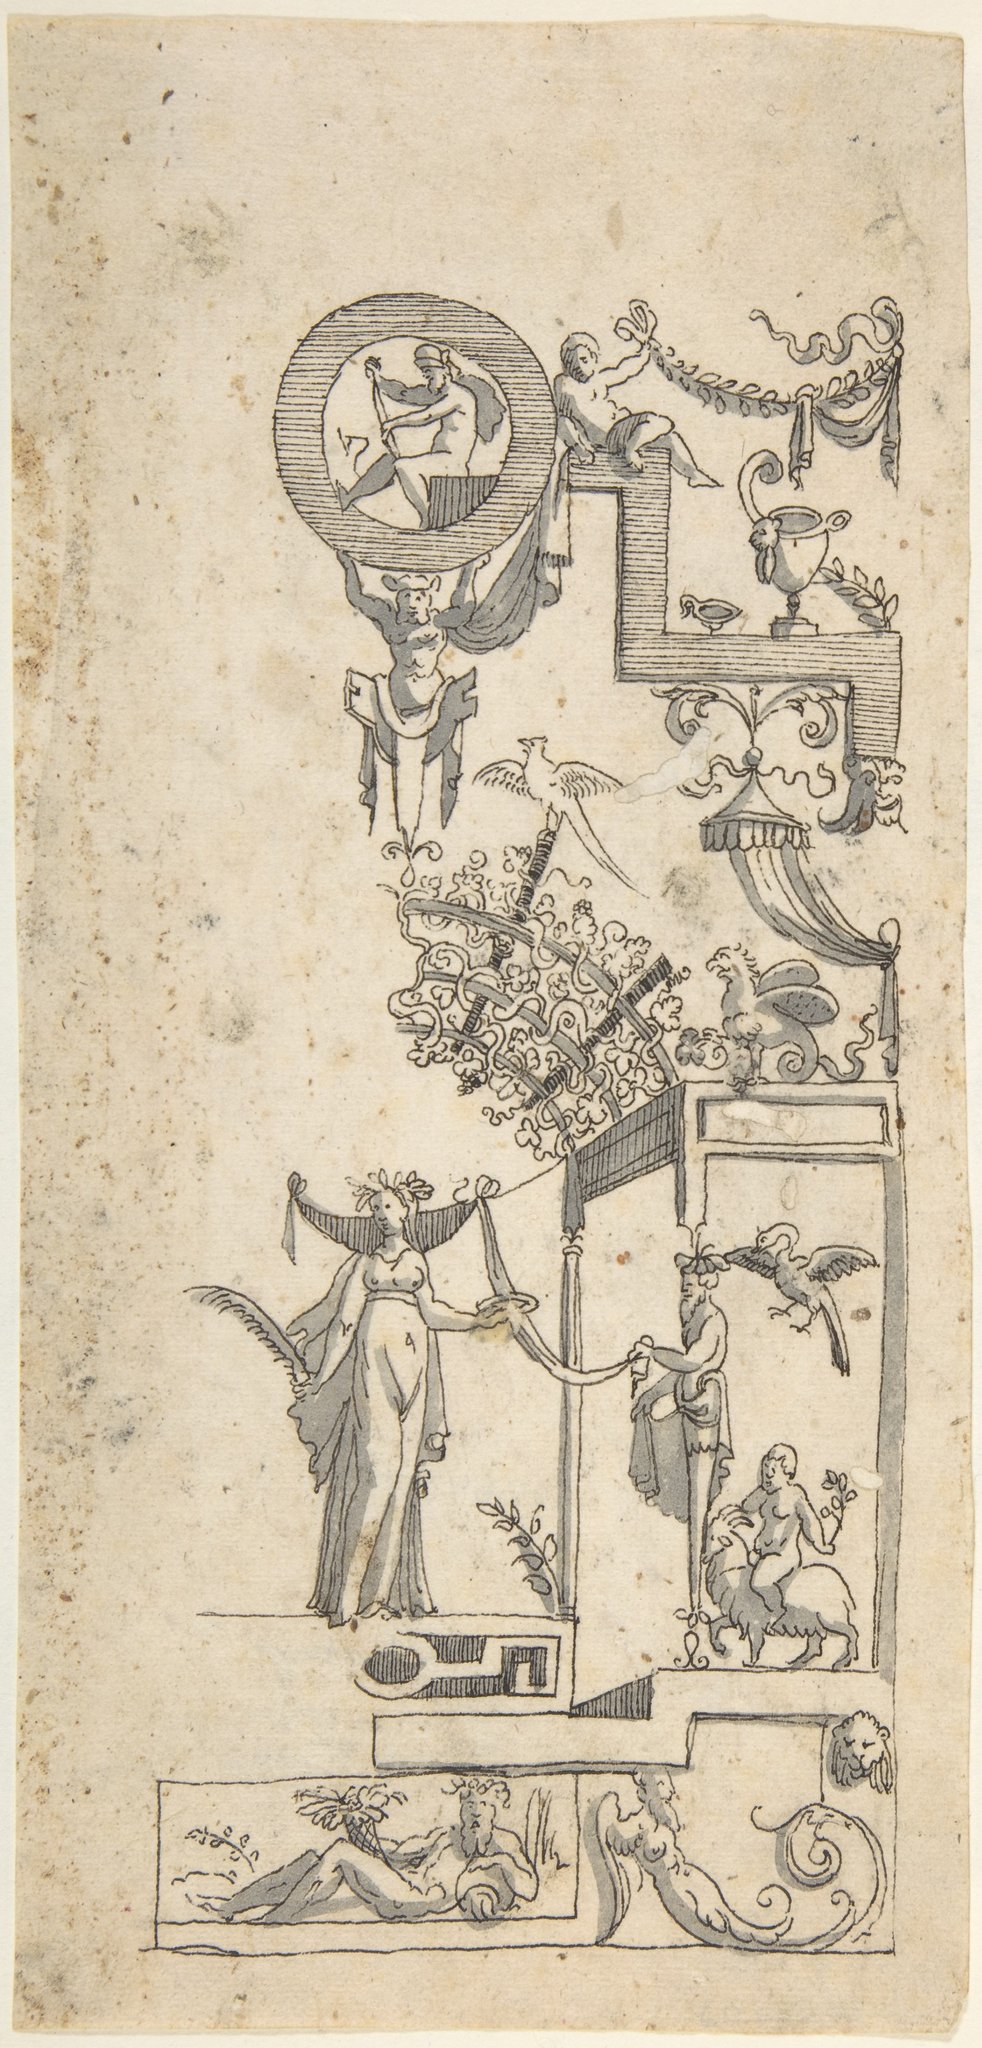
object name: ornament architecture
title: Grotesque with a Victory Figure Under an Overgrown Pergola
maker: anonymous, italian, 16th century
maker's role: artist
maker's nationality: italian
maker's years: 1500-1600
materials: ink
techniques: brush, pen, wash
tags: birds,grotesques,ornament,women